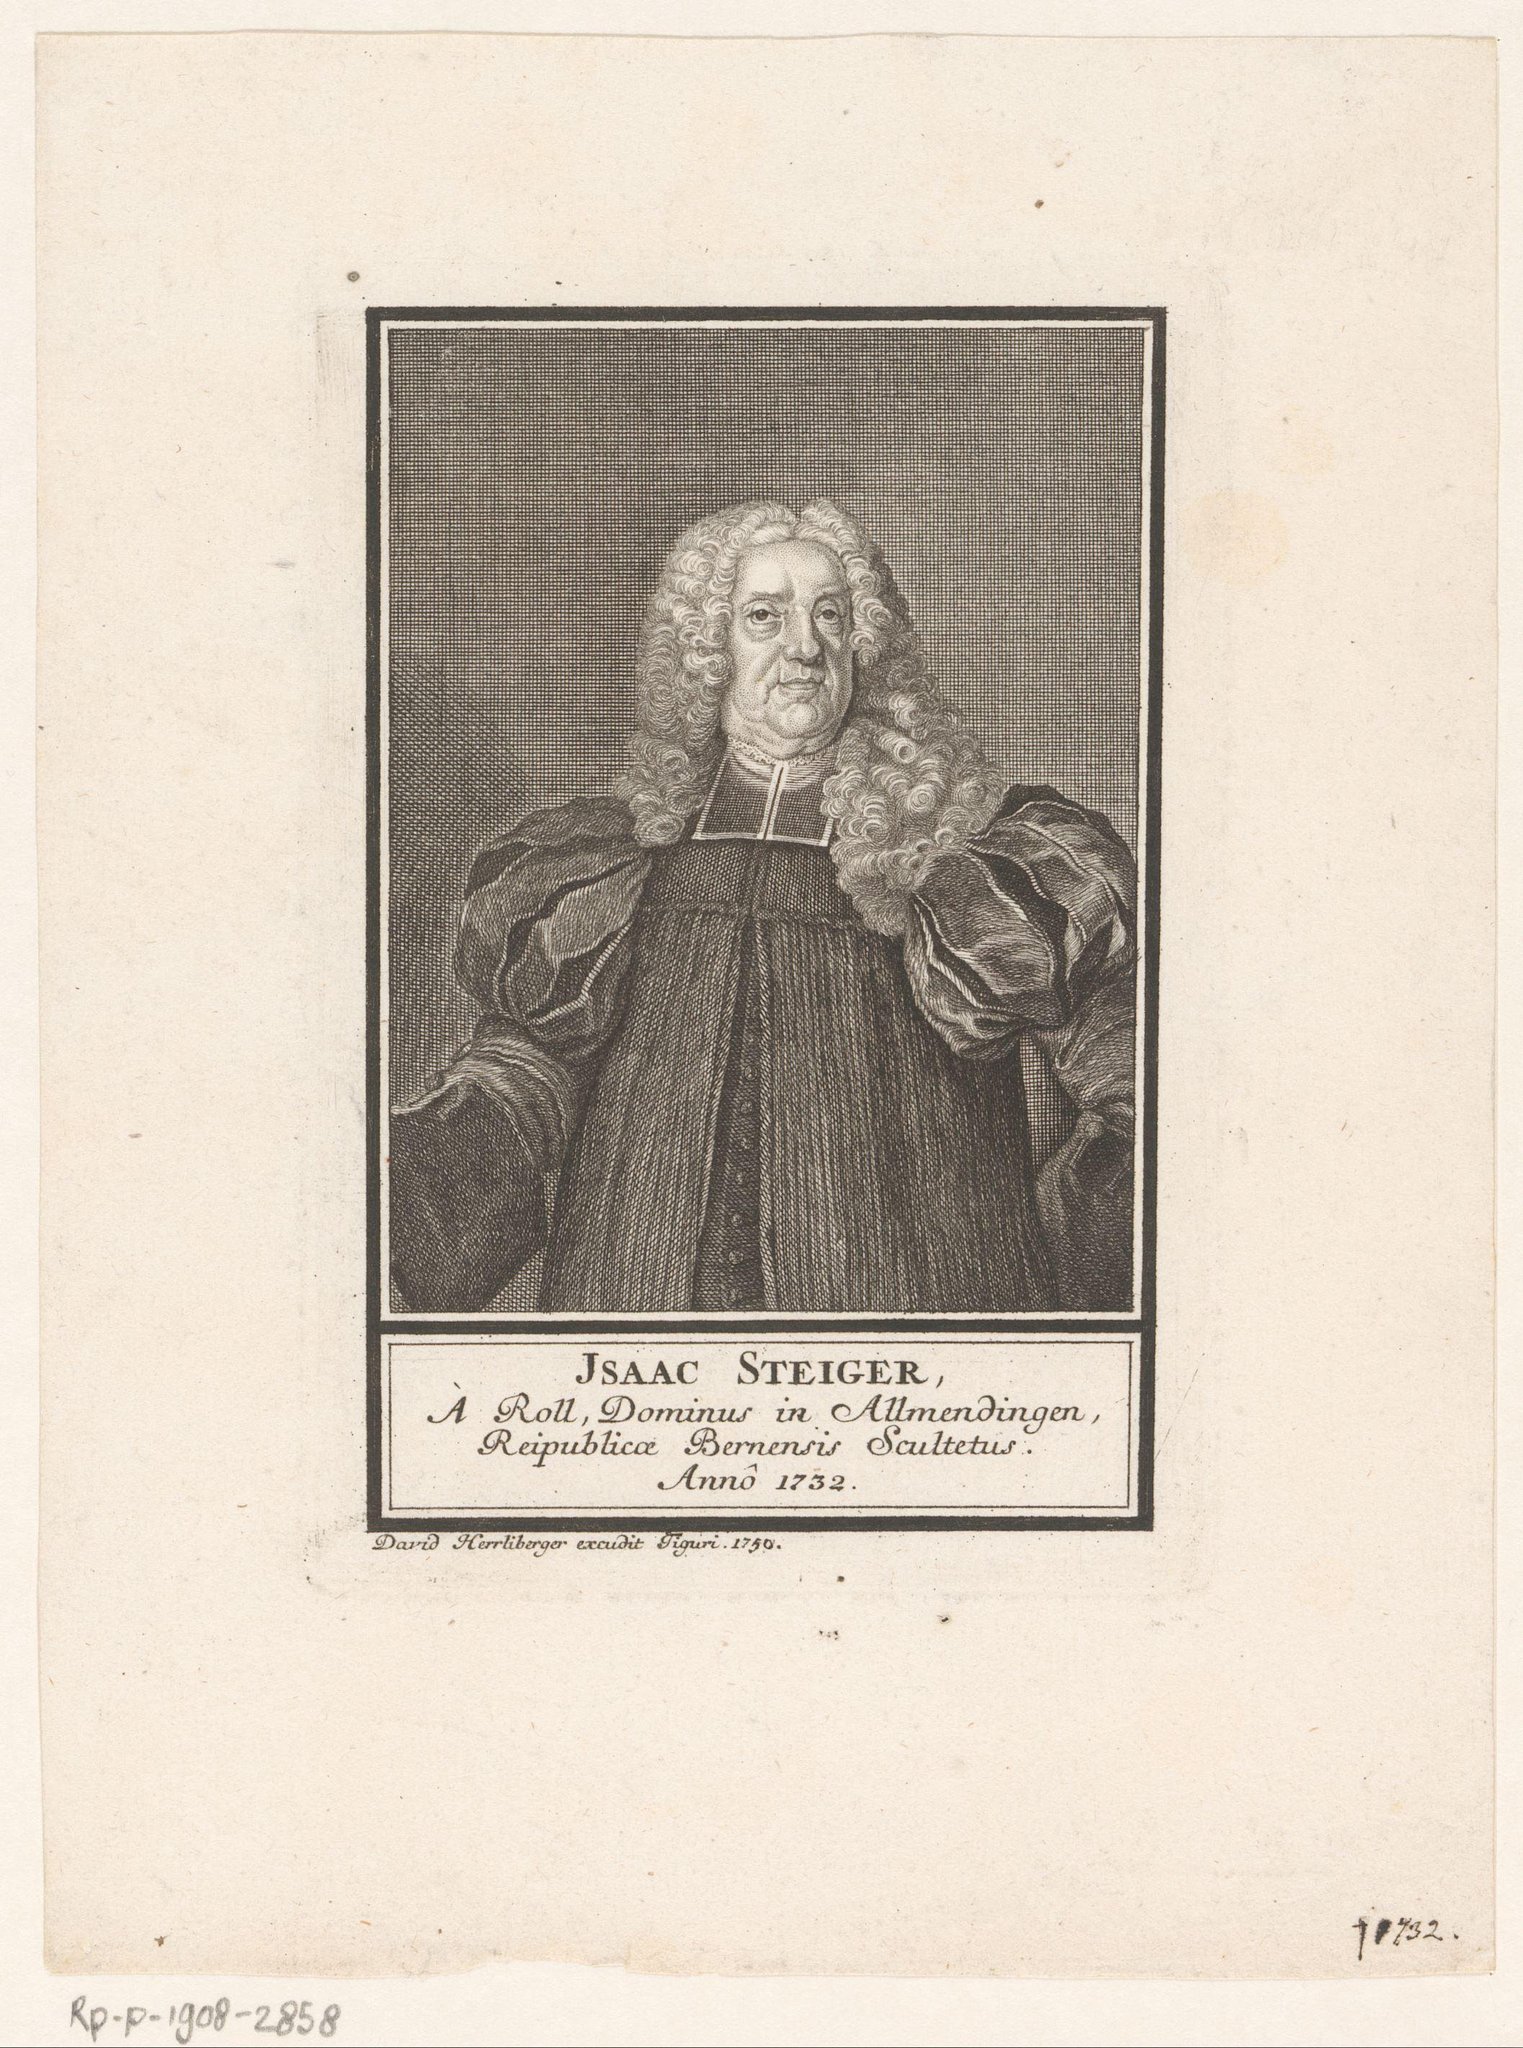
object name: print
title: Portret van Isaak Steiger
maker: david herrliberger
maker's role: print maker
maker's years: 1697-1777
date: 1750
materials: paper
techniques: engraving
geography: zurich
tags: mayor, mayor, burgomaster, historical persons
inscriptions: collector's mark: Lugt 2228